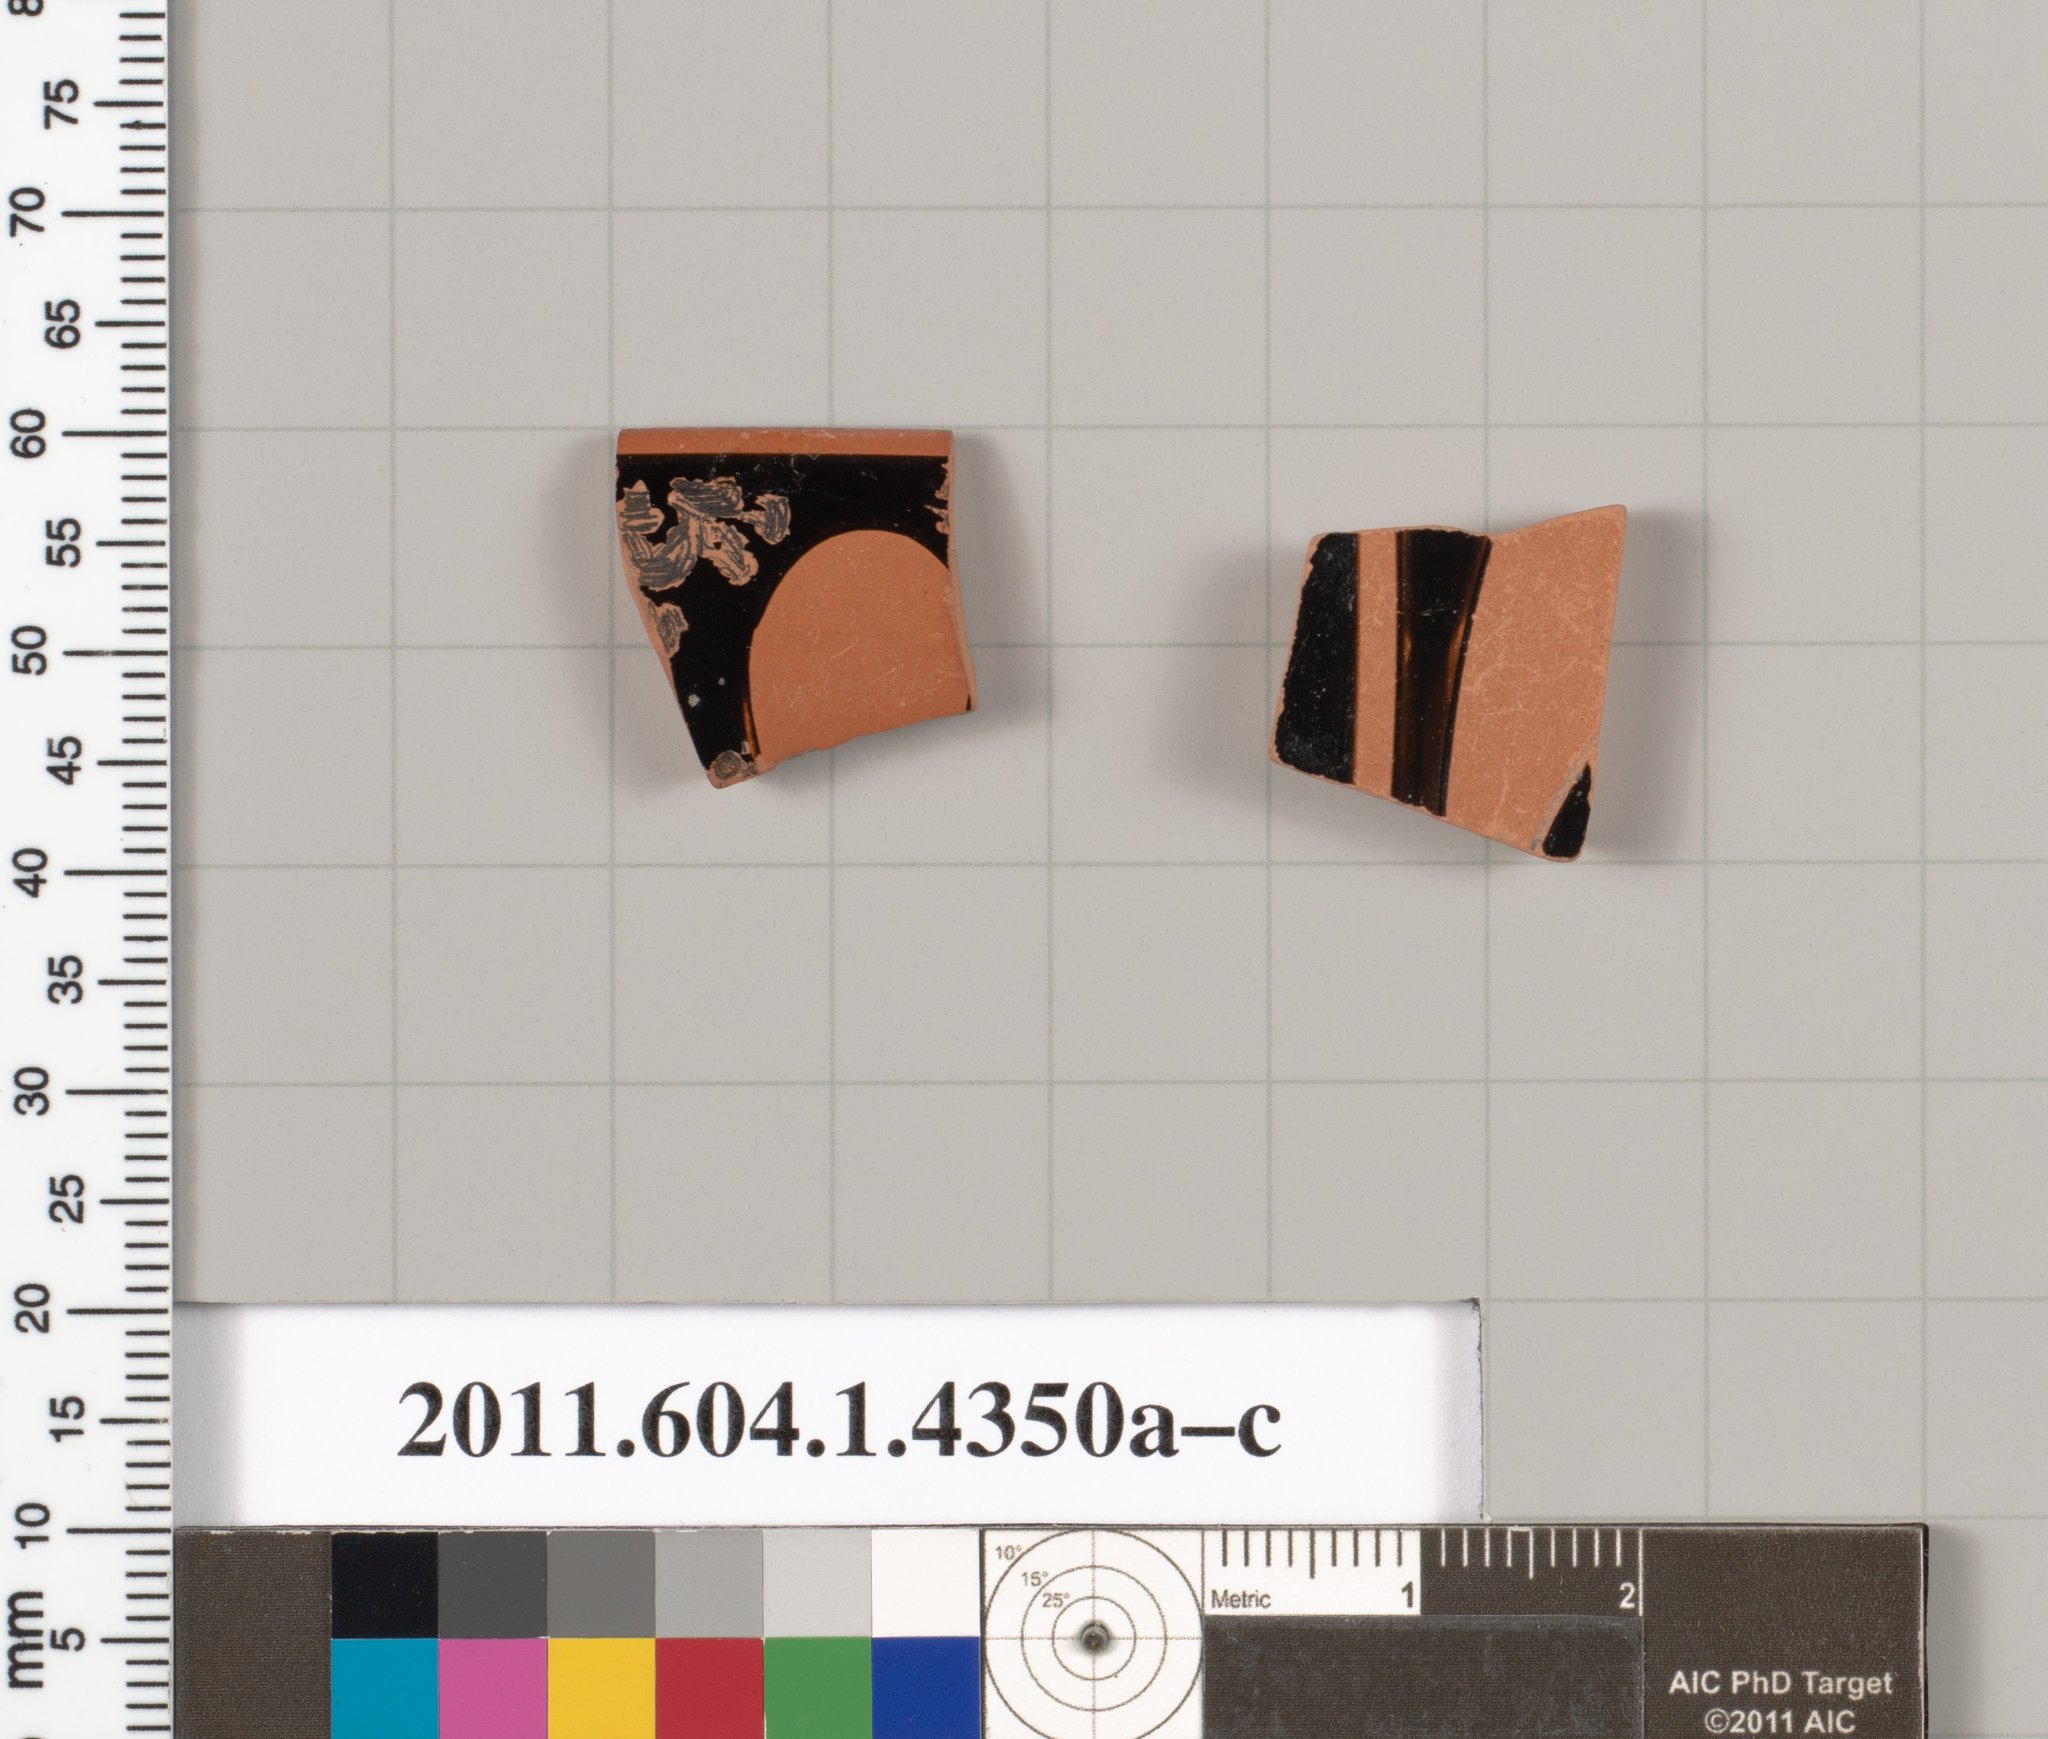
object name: kylix fragment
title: Terracotta fragments of kylikes (drinking cups)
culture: greek, attic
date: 520-500 BCE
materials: terracotta